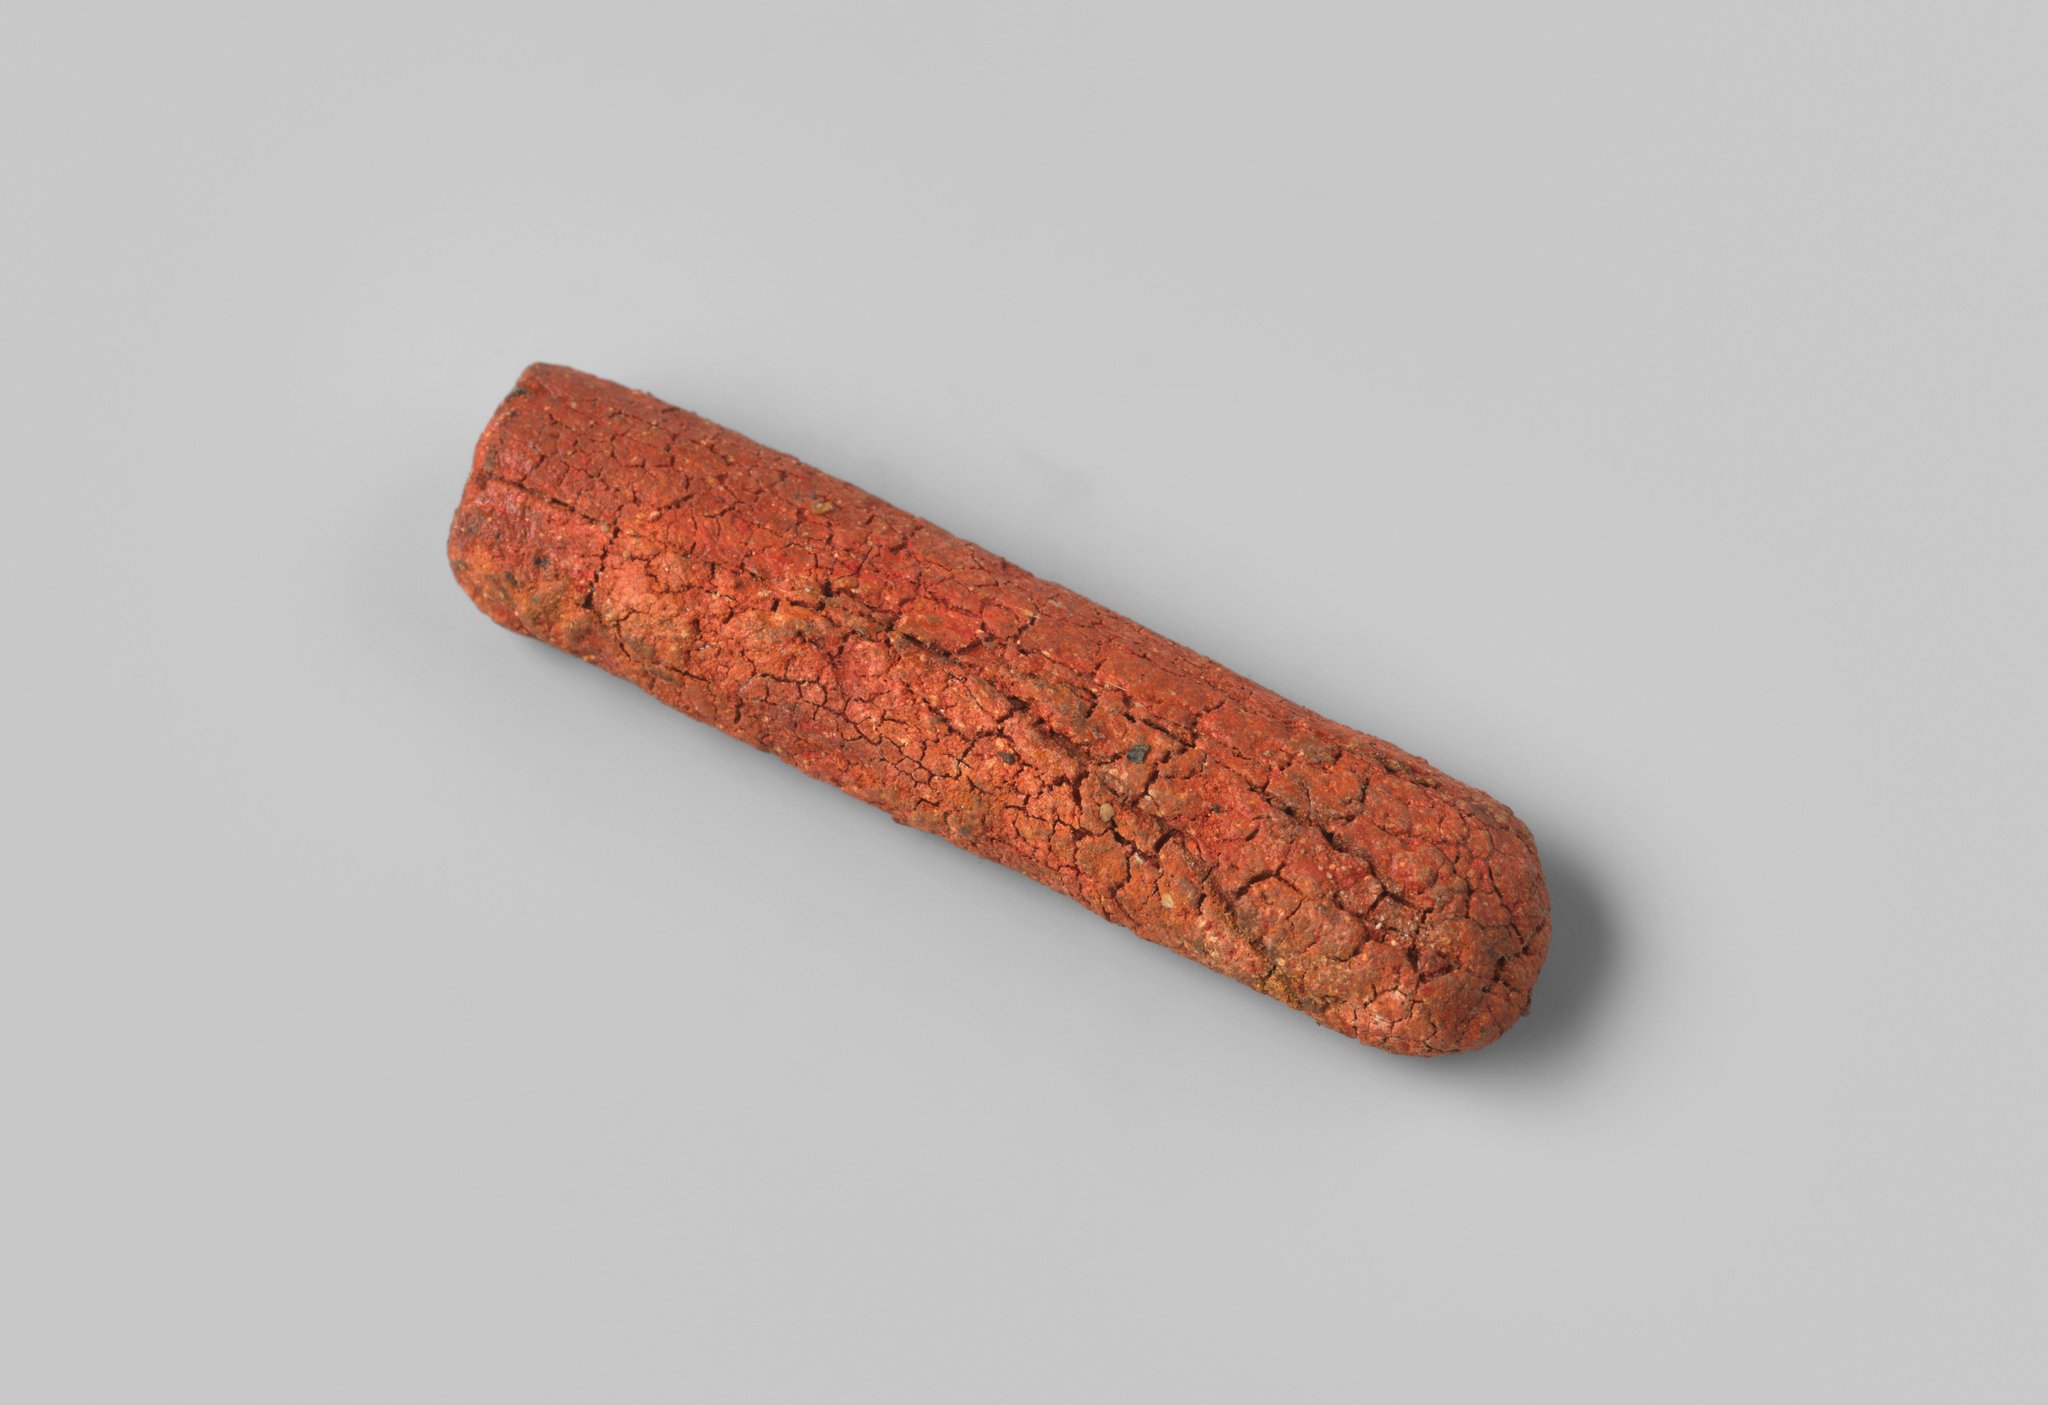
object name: sealing wax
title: Zegellak uit het wrak van de Oost-Indiëvaarder Hollandia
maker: Anonymous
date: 1700-1743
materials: wax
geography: netherlands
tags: verenigde oostindische compagnie, hollandia (schip), annet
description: Marking and proving, sealing wax, red; fragm, sim. NG 1975-50H446, one rounded end.